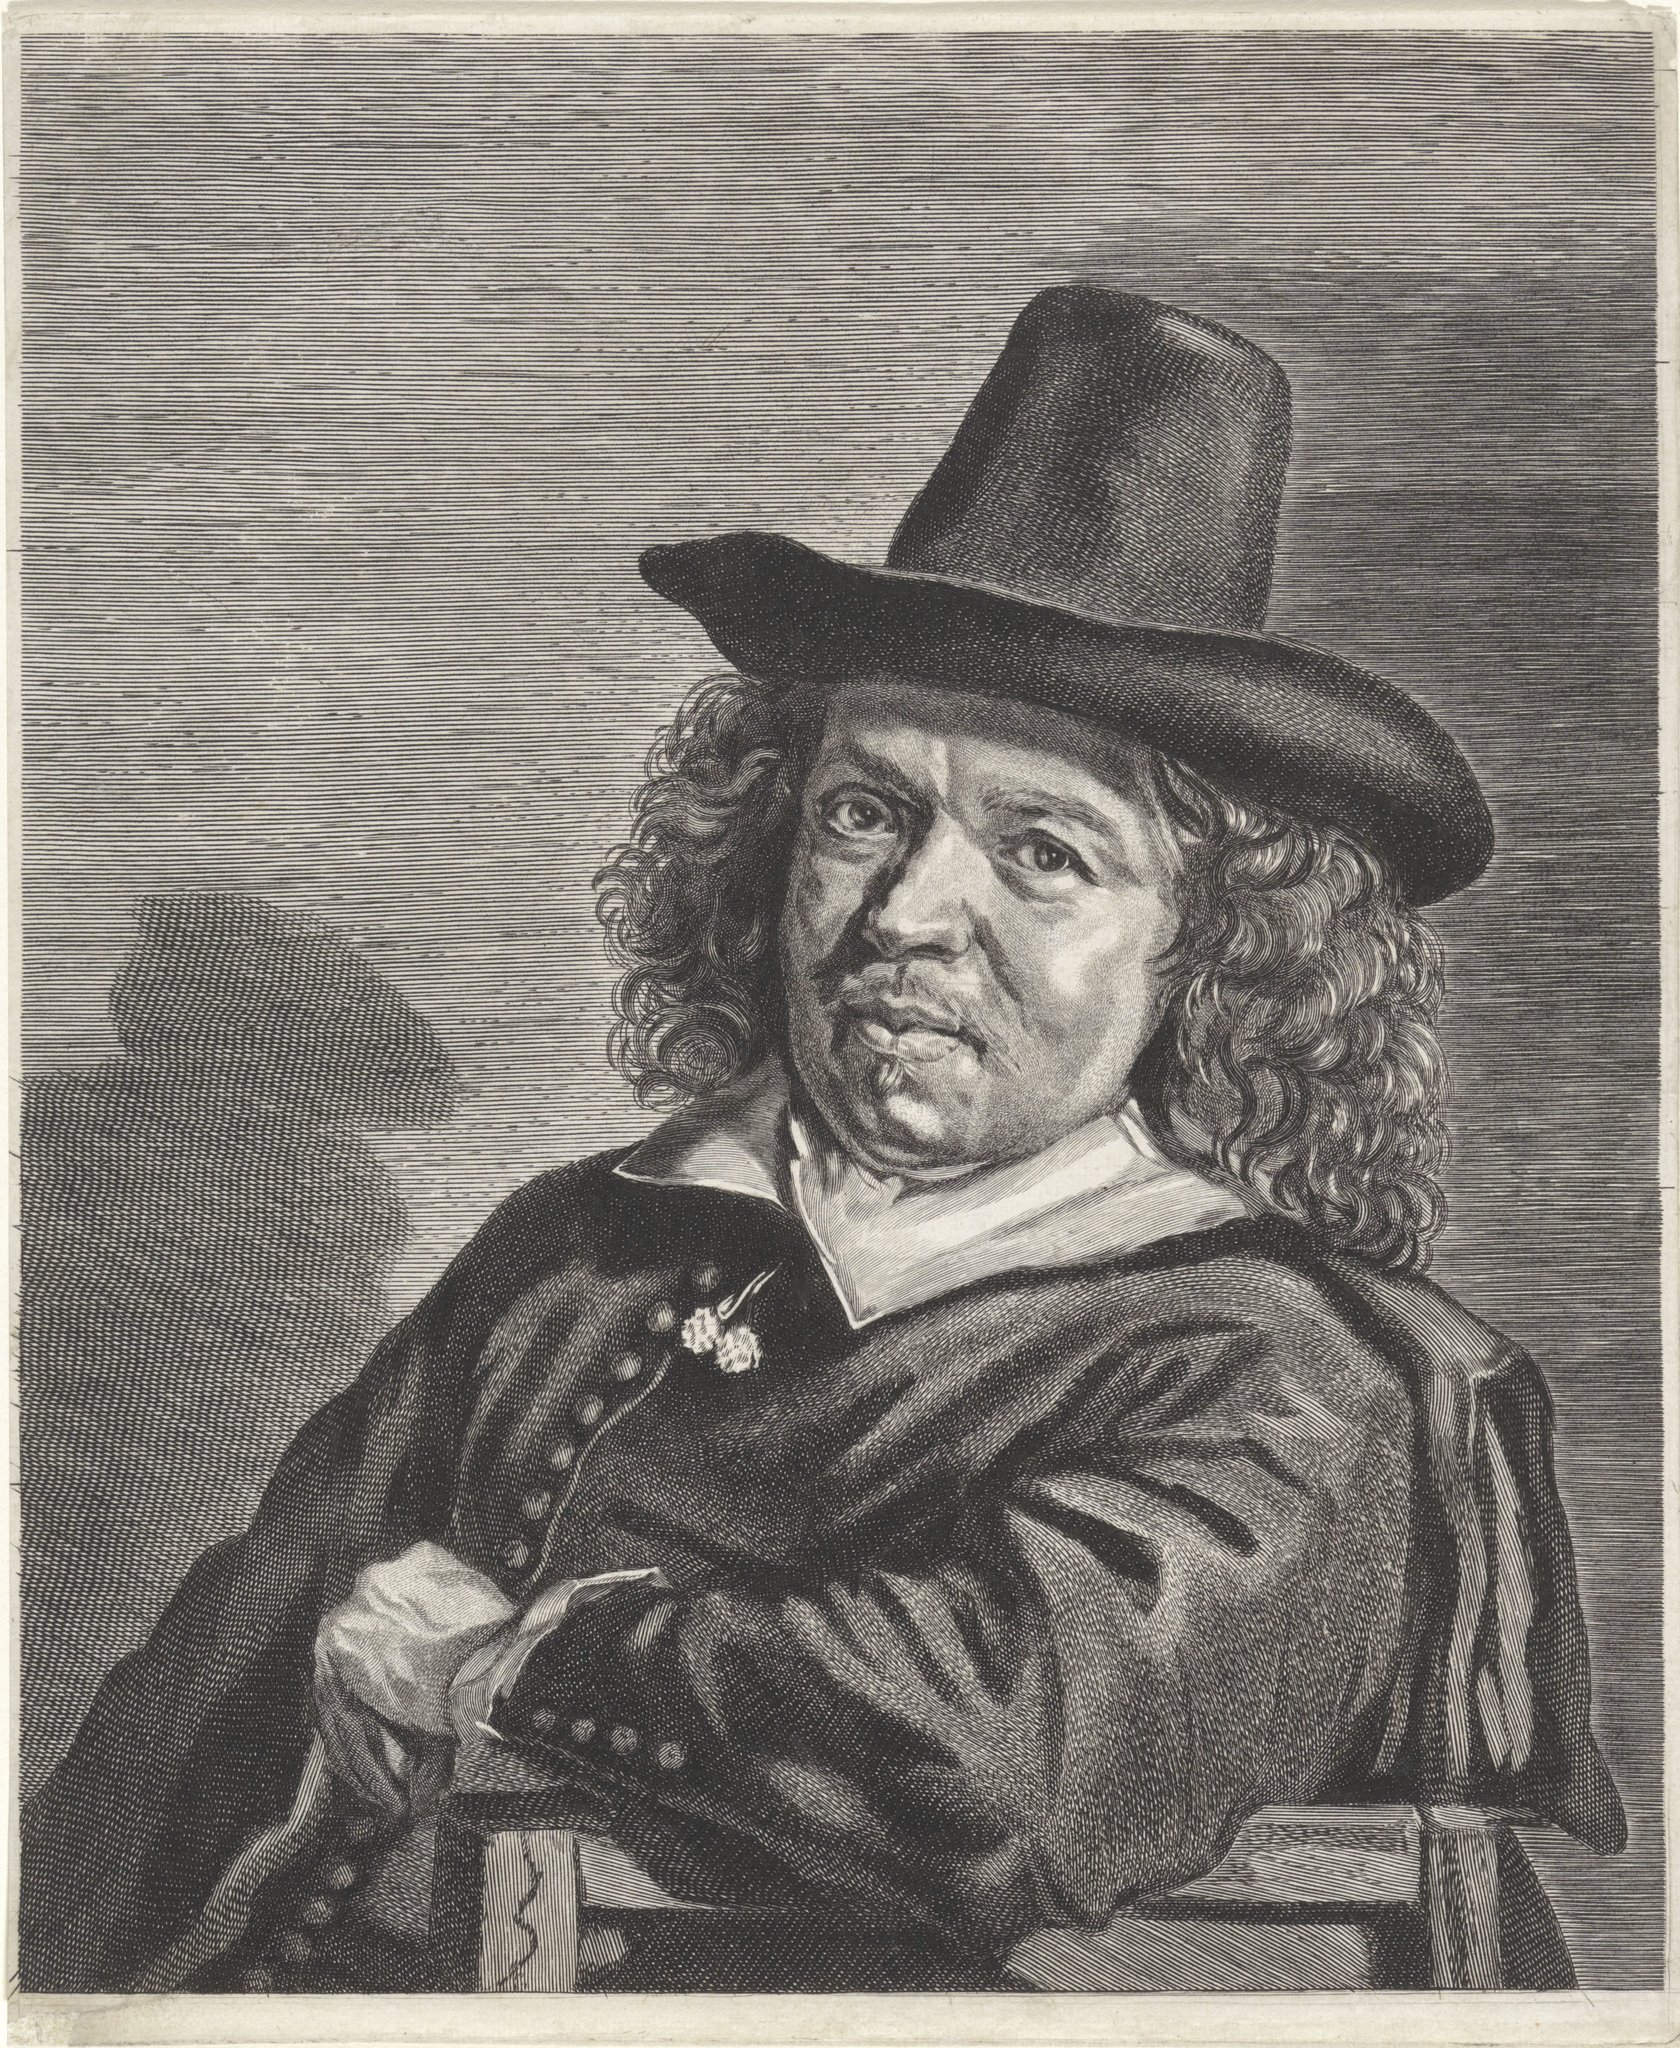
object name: print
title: Portret van Frans Jansz. Post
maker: jonas suyderhoef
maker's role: draughtsman, print maker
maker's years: 1613-1686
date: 1650-1686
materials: paper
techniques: engraving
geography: haarlem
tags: painter, frans jansz post, portrait, self-portrait of painter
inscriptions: collector's mark: Lugt 240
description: Portret van Frans Jansz. Post, prentmaker, tekenaar en schilder, zittend in een armstoel met een hoed op het hoofd.